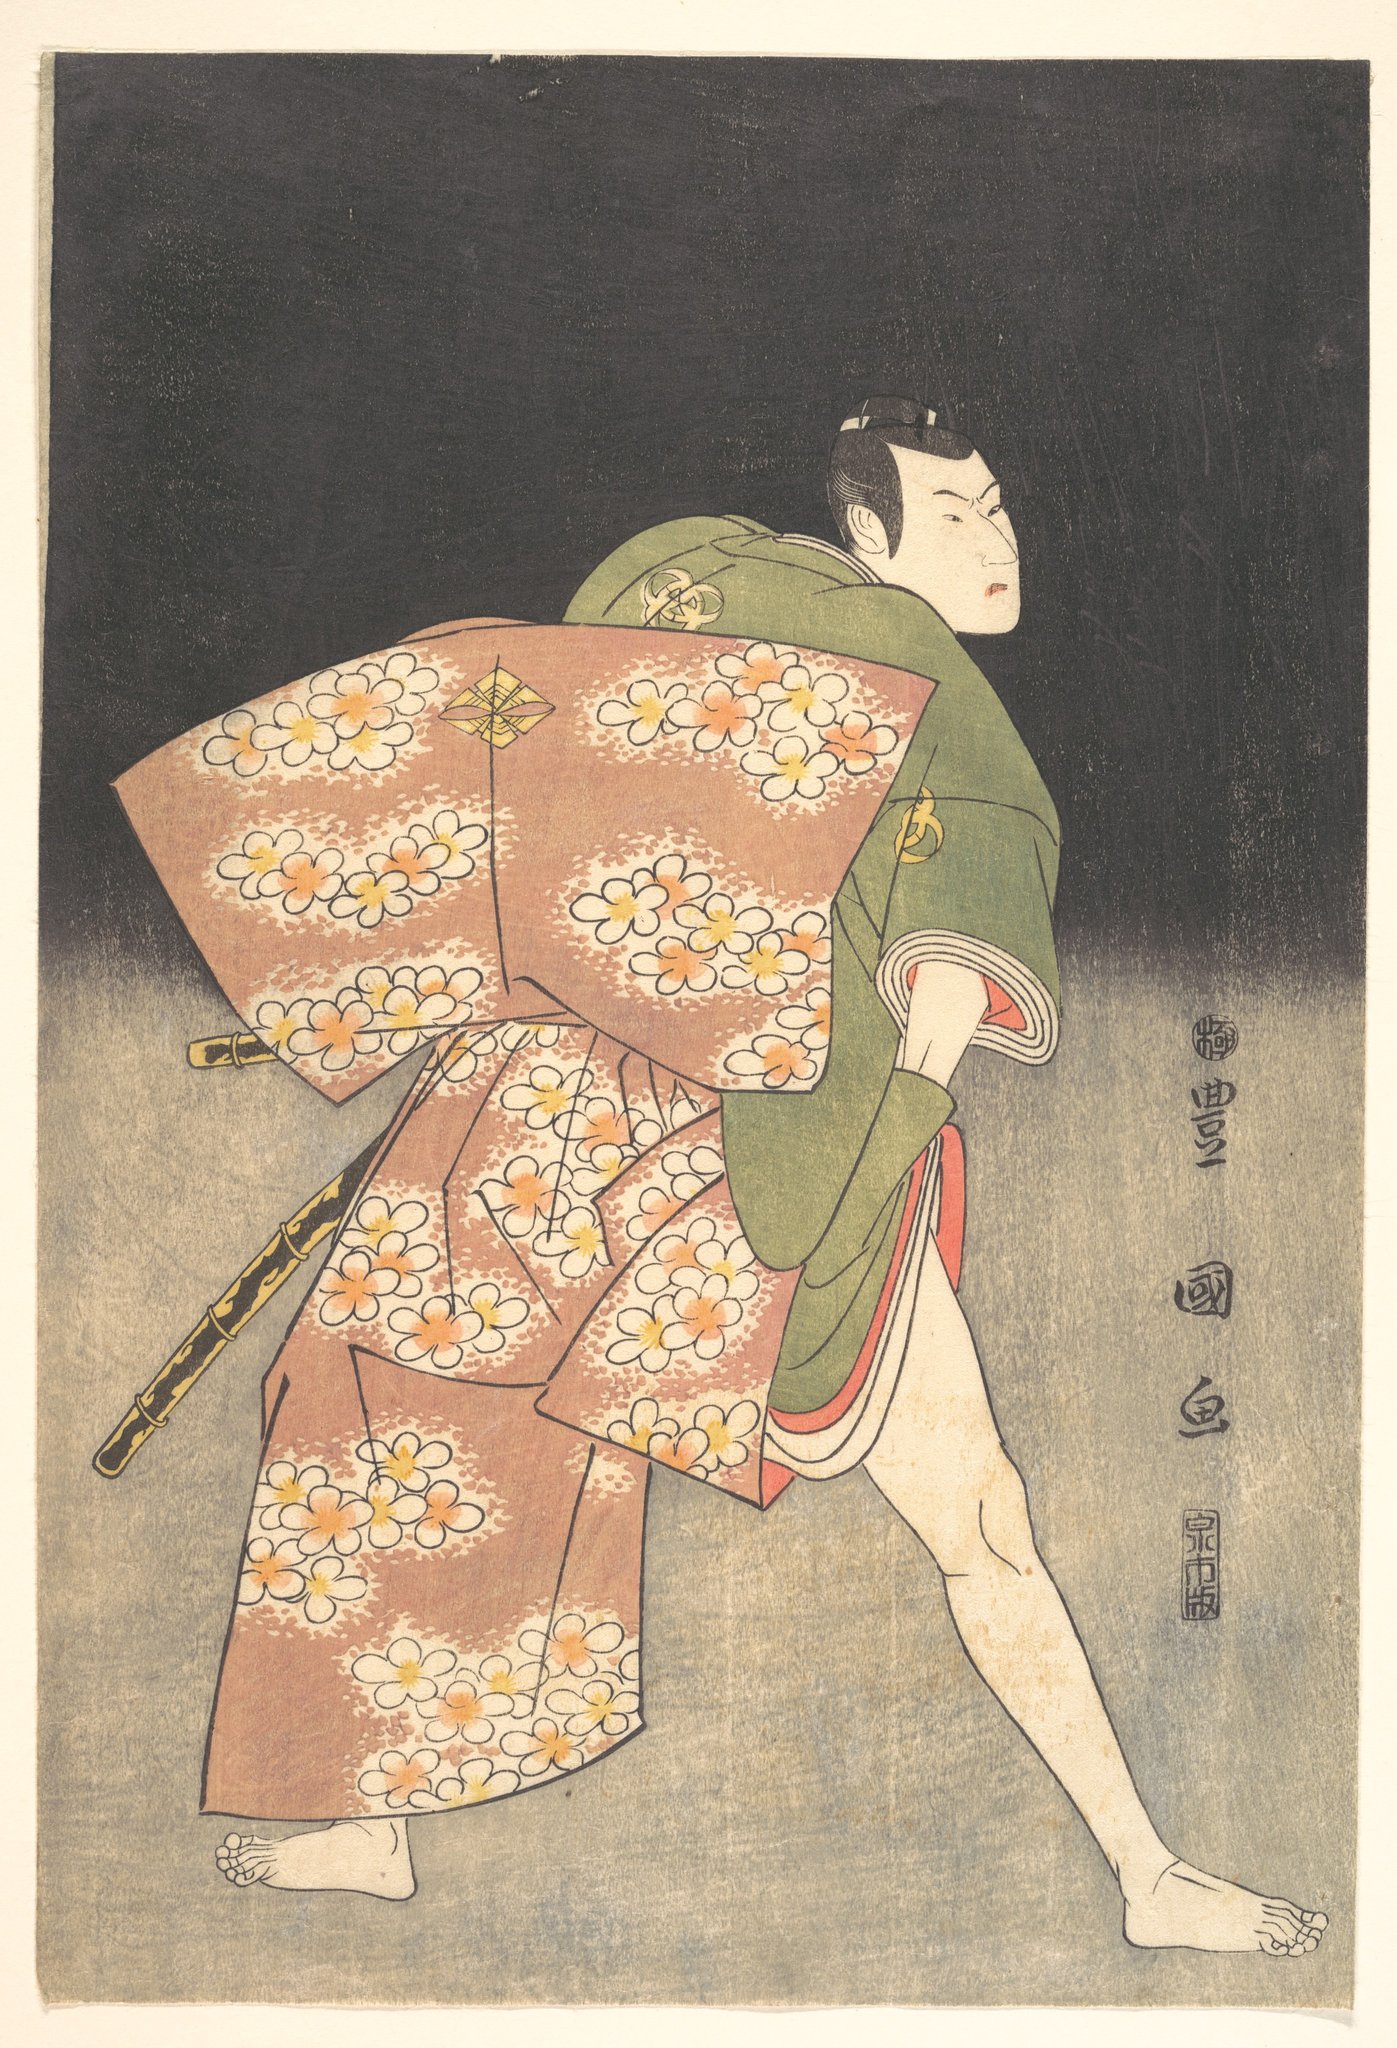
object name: print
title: Bandō Minosuke (Mitsugorō III) in the Role of a Young Samurai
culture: japanese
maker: utagawa toyokuni i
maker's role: artist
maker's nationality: japanese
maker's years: 1769-1825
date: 1796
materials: ink, paper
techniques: woodblock print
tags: swords,men,actors